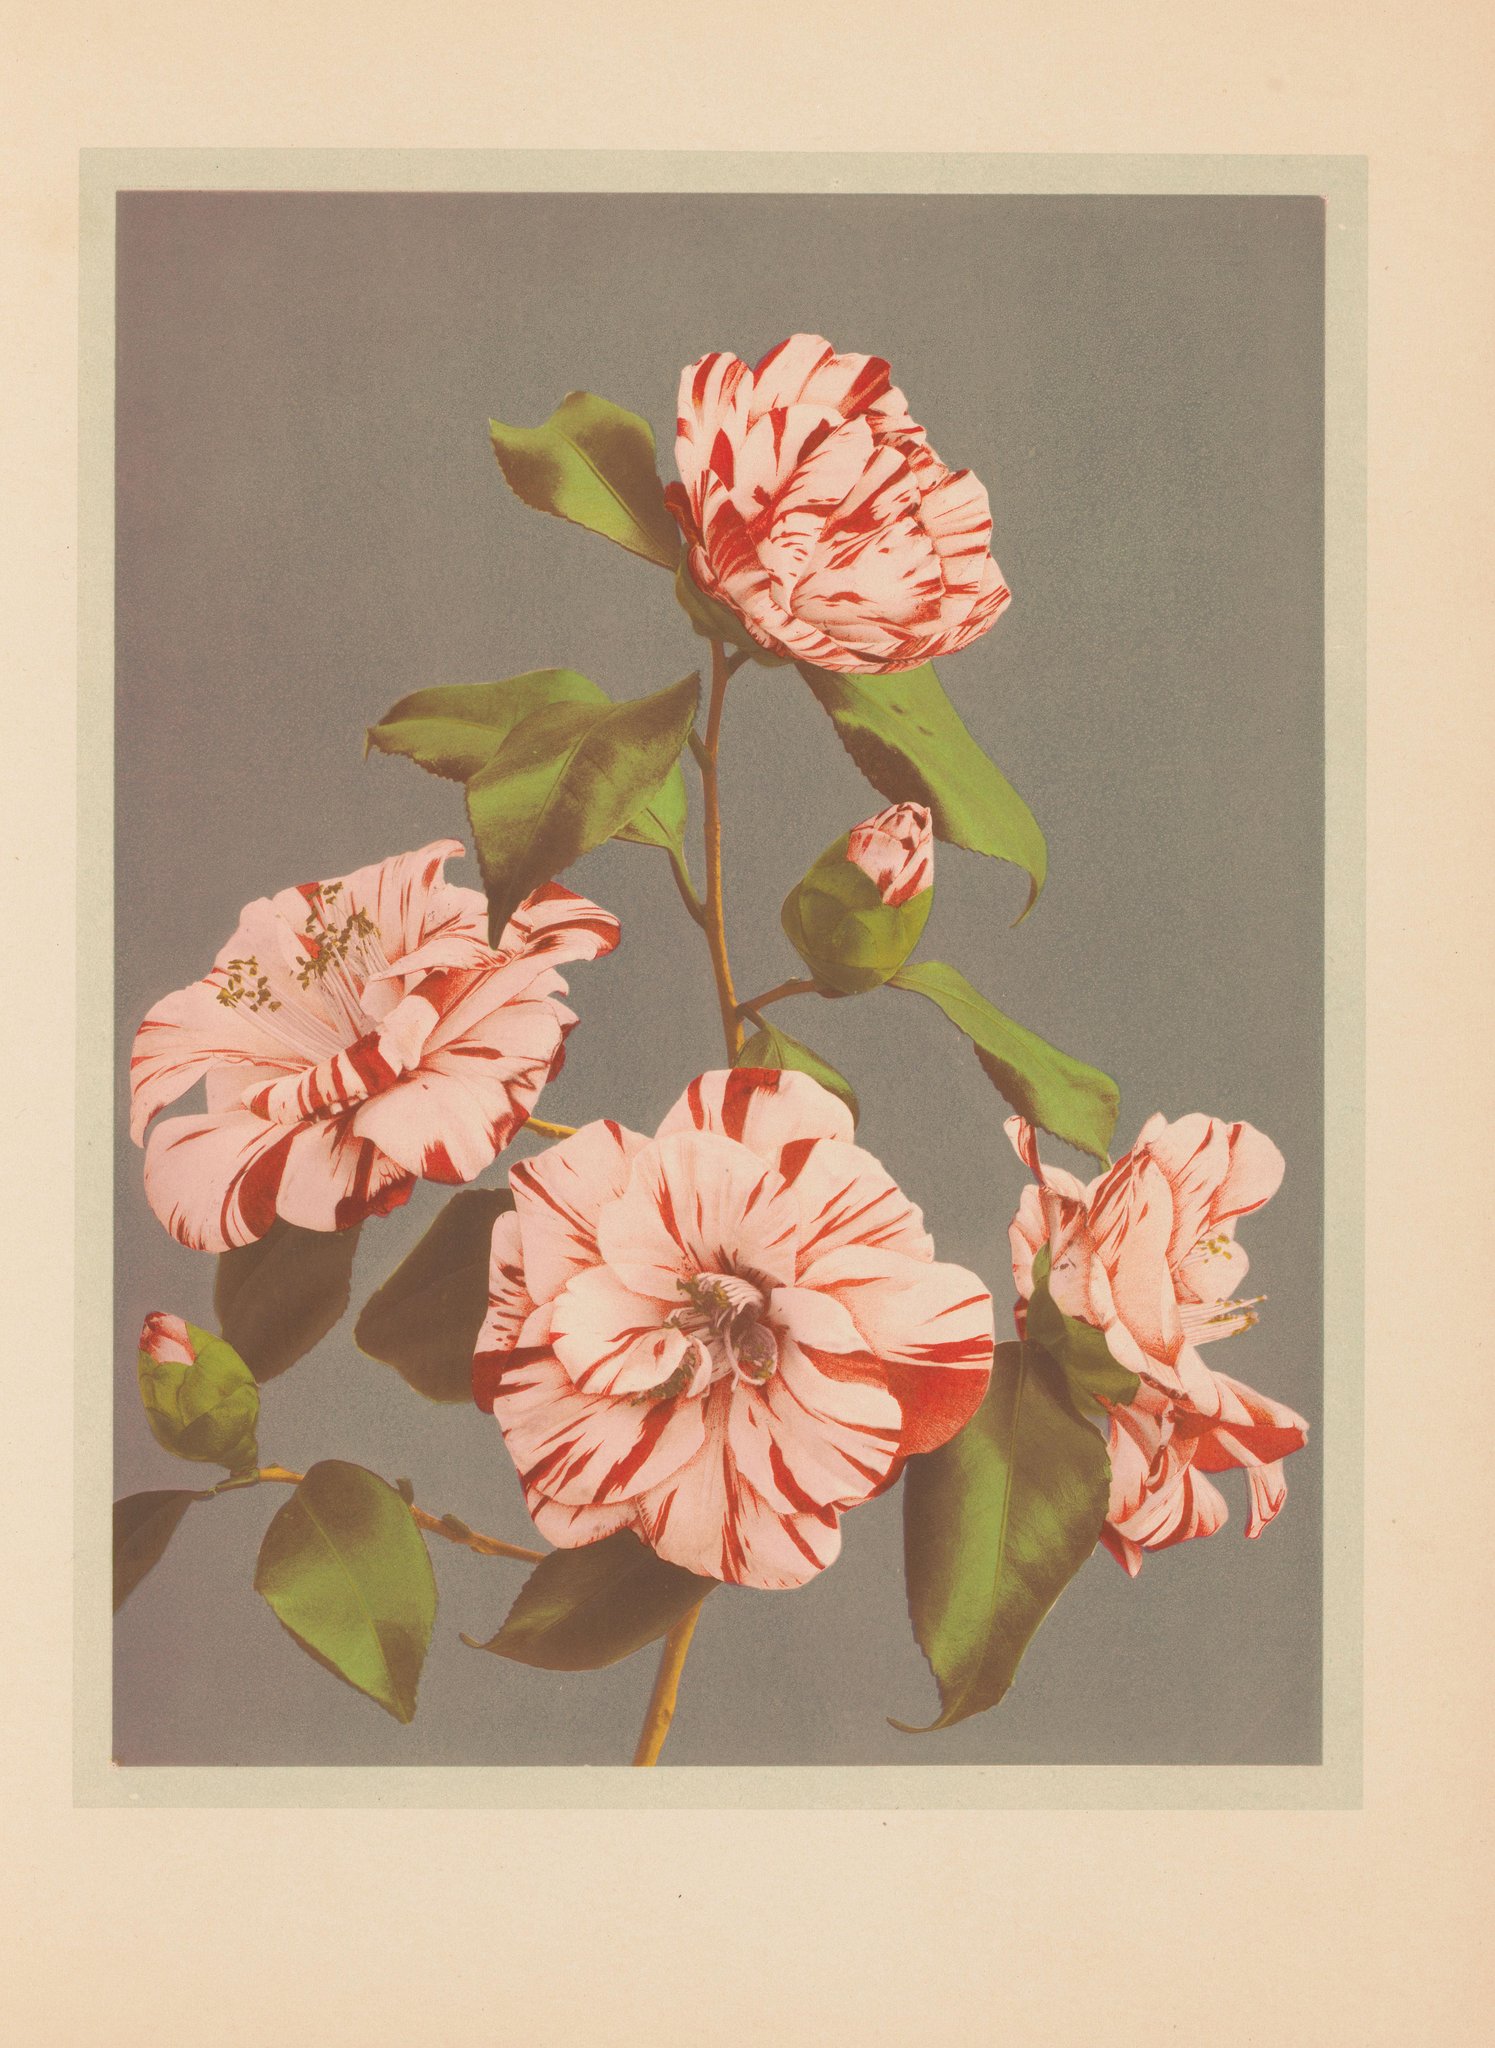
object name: photomechanical print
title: Camelia japonica of Japanse roos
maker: kazumasa ogawa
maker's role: auteur, fotograaf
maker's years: 1860-1929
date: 1890-1895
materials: paper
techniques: photograph, lithograph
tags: flowers: rose